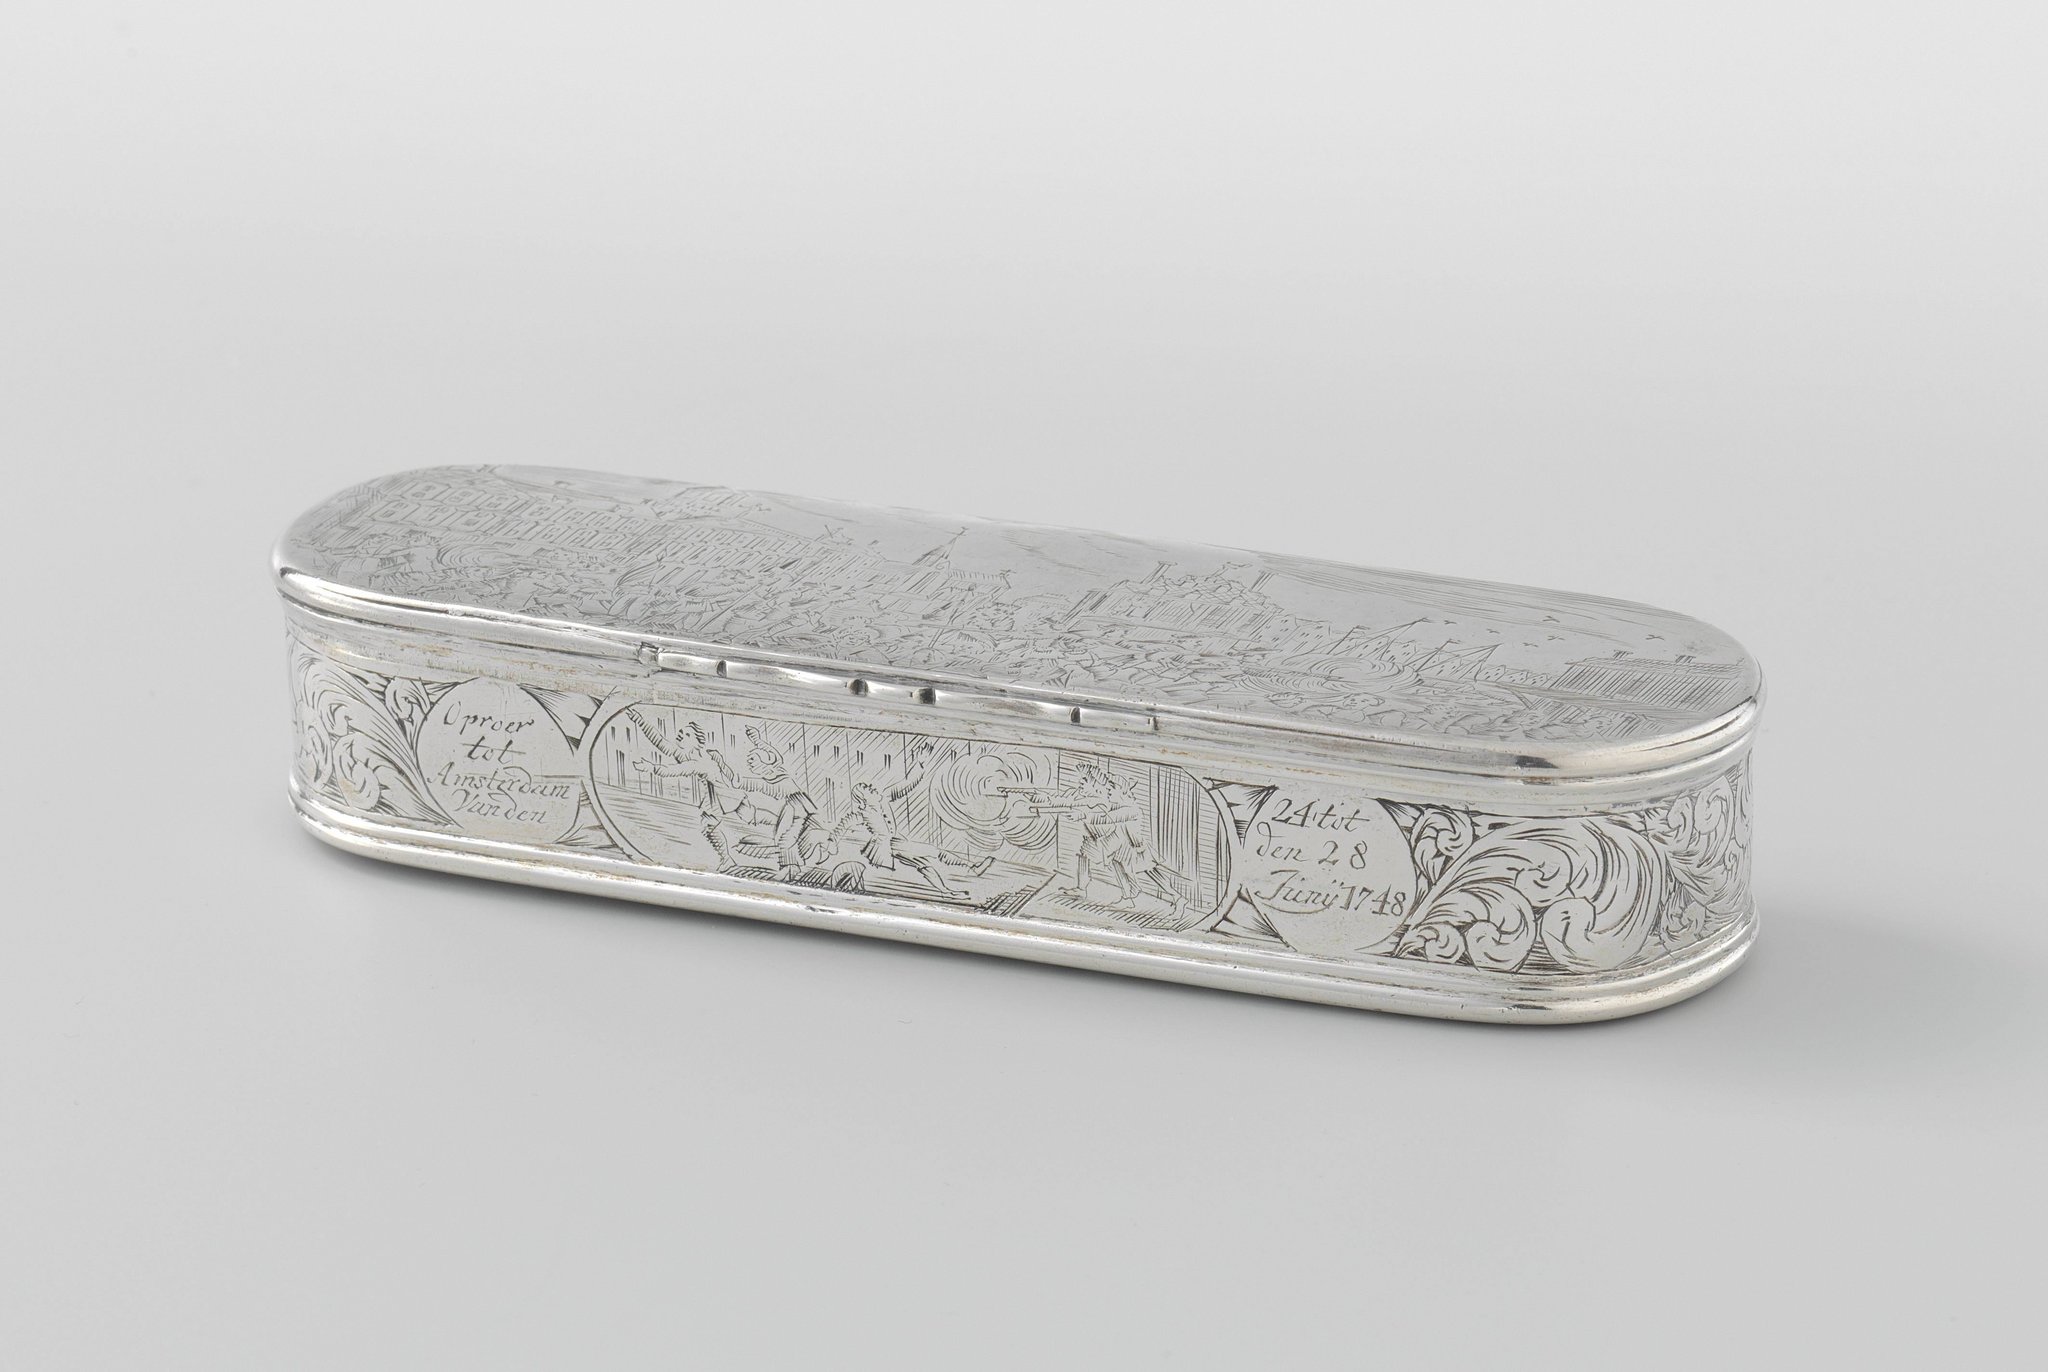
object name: tobacco box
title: Tabaksdoos 'pachtersoproer'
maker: jacobus koning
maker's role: silversmith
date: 1764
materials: silver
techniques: engraving, forging, striking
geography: amsterdam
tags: amsterdam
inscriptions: inscription: ‘Gedaat’, mark: ‘x x x (boven elkaar, teken van Amsterdam); man met kroon enscepter (J.Koning)’, mark: ‘KVR)E (Jaarletter 1764)’, inscription: ‘24 tot / den 28 / Junij 1748’, inscription: ‘oproer / tot / Amsterdam / Van den’, inscription: ‘de Zweed’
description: Tabaksdoos, de korte einden rond, geheel versierd met gravures. Het bijgaande briefje (NG-KOG-1481-B) geeft een toelichting op de voorstellingen. Deksel: bij een executie op de Dam schoot de schutterij op de menigte. Onderzijde: plundering van een pachtershuis op het Singel. Achterzijde: het doden van een Zweed, een der voornaamste oproerkraaiers. Op de voorzijde een afbeelding van schutters schietend op vluchtende mensen. Verder plantmotieven en tekst-cartouches. Op de binnenzijde van het scharnierend deksel een etiket: NAA / 3160.